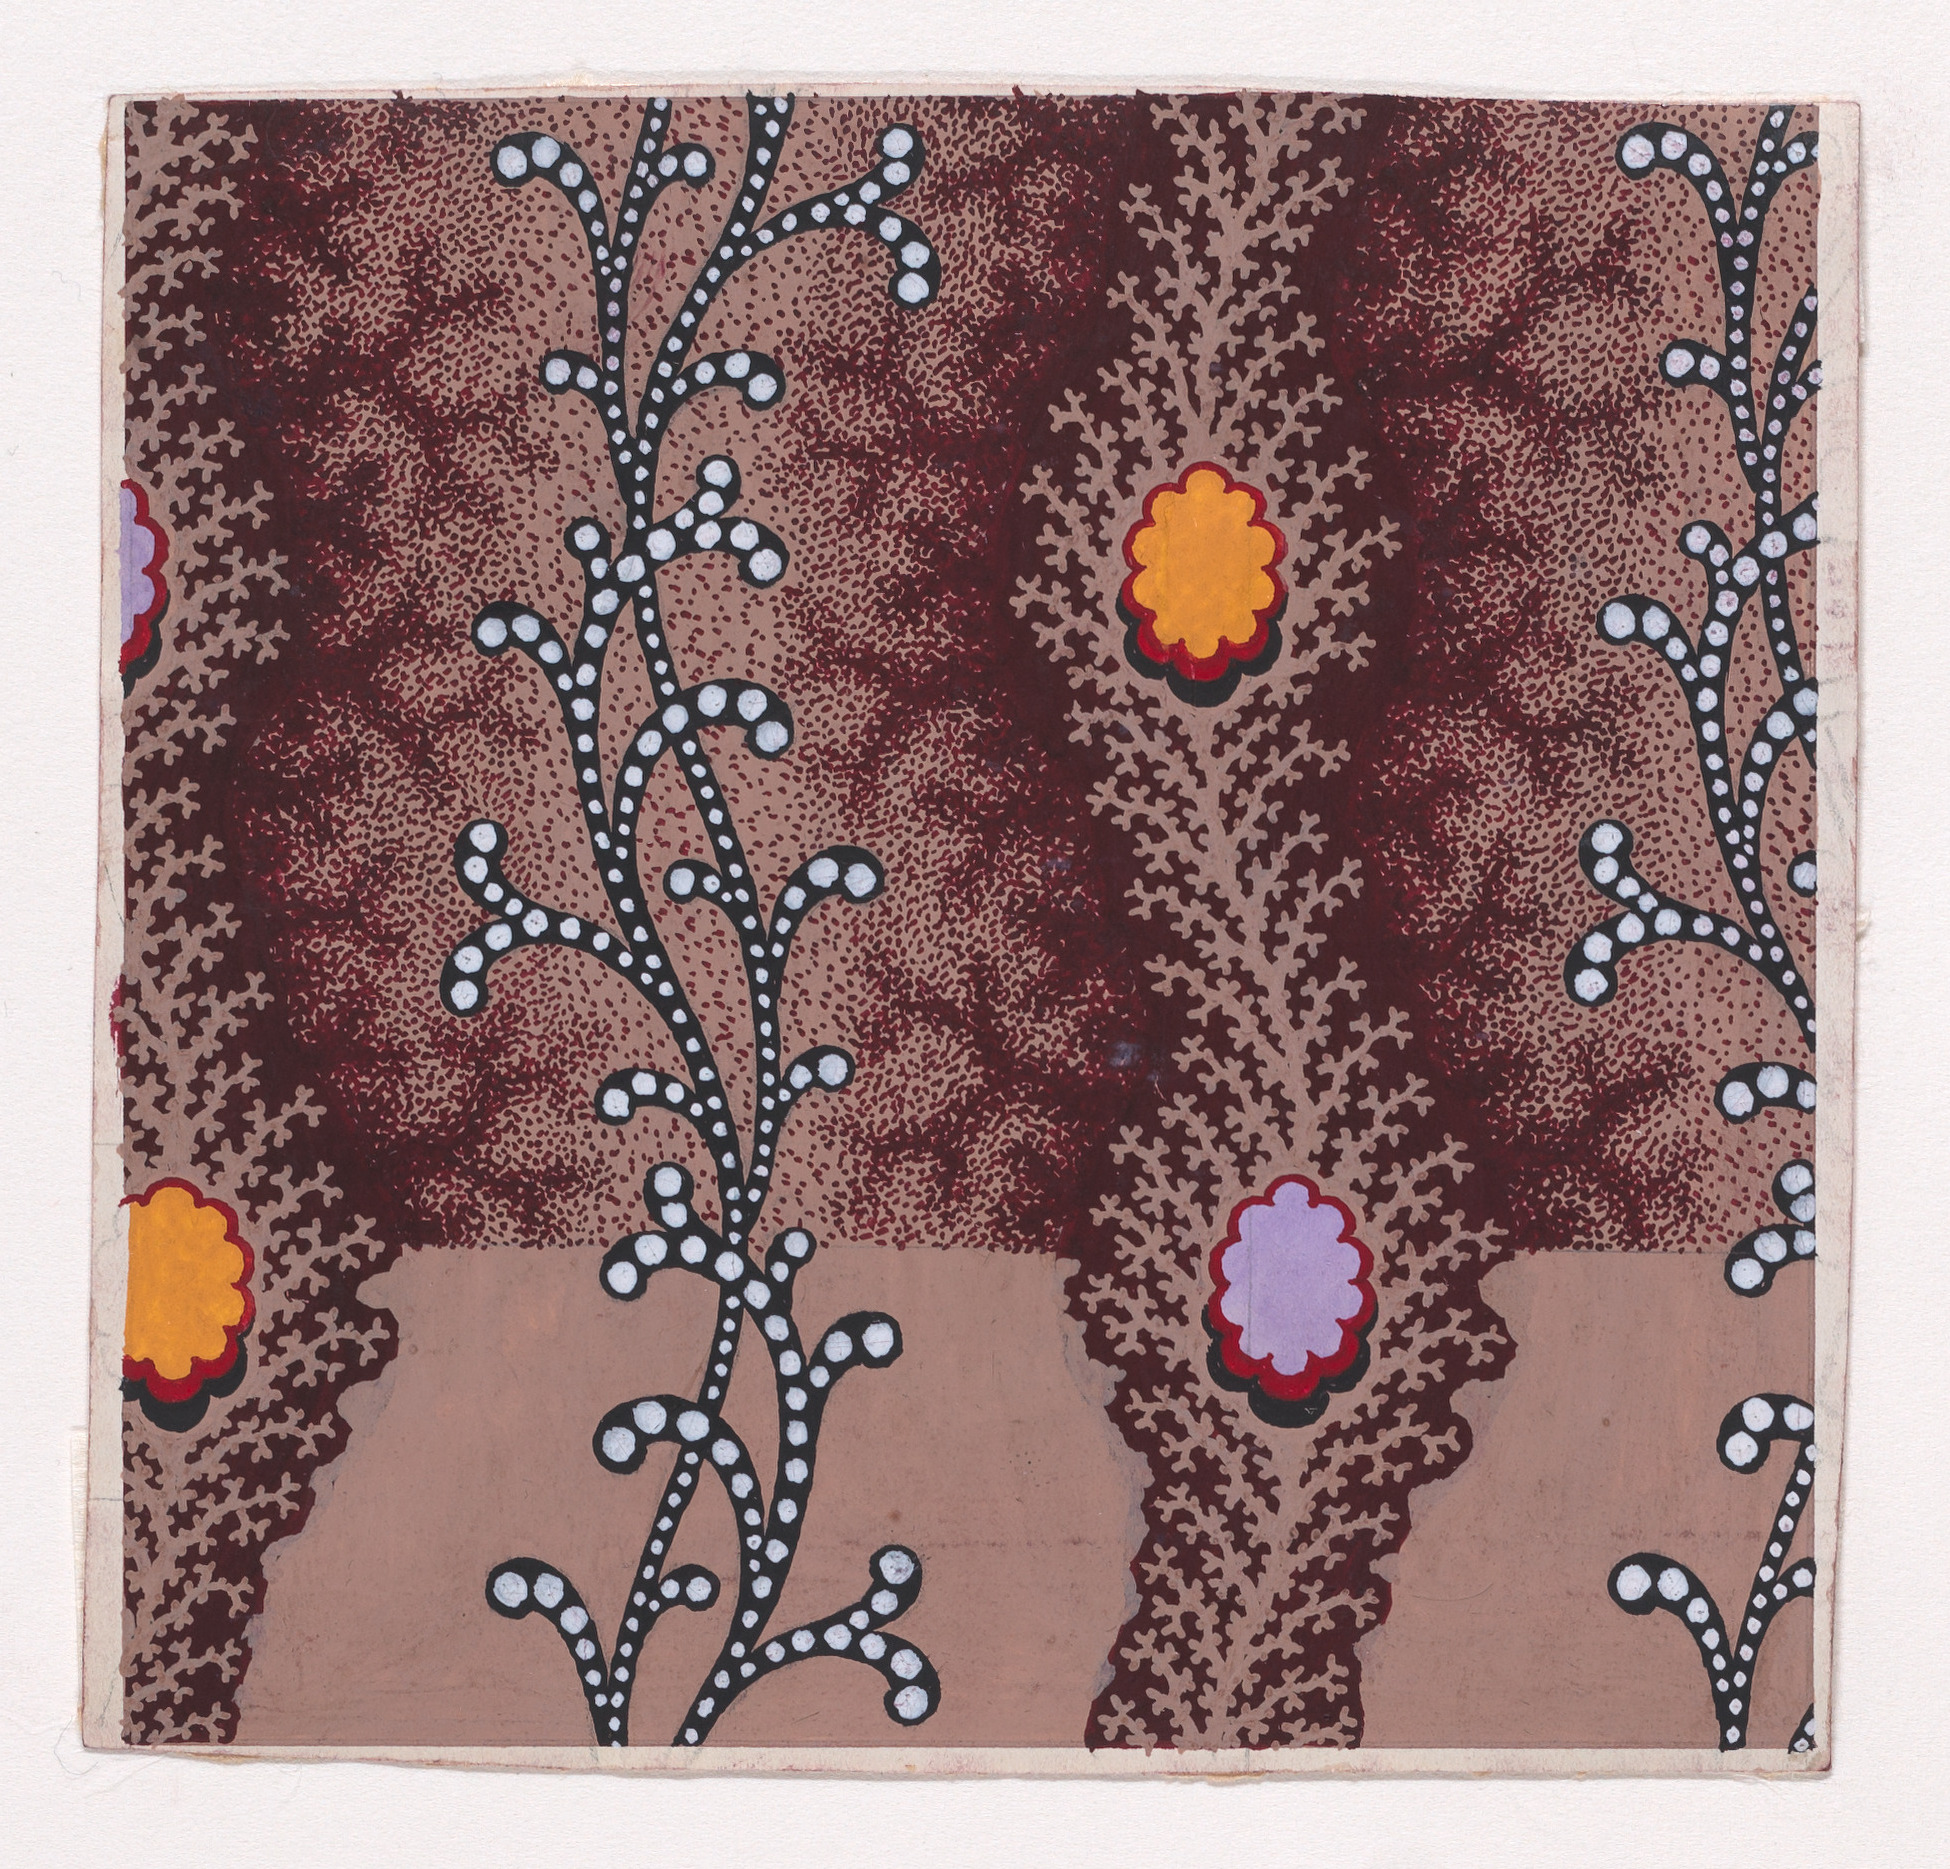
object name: drawing ornament architecture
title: Textile Design with Alternating Vertical Scrolls Decorated with Pearls and Undulating Garlands of Branches Decorated with Rosettes and with Offsetting Branches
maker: anonymous, alsatian, 19th century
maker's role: artist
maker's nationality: alsatian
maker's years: 1800-1900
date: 1840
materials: gouache